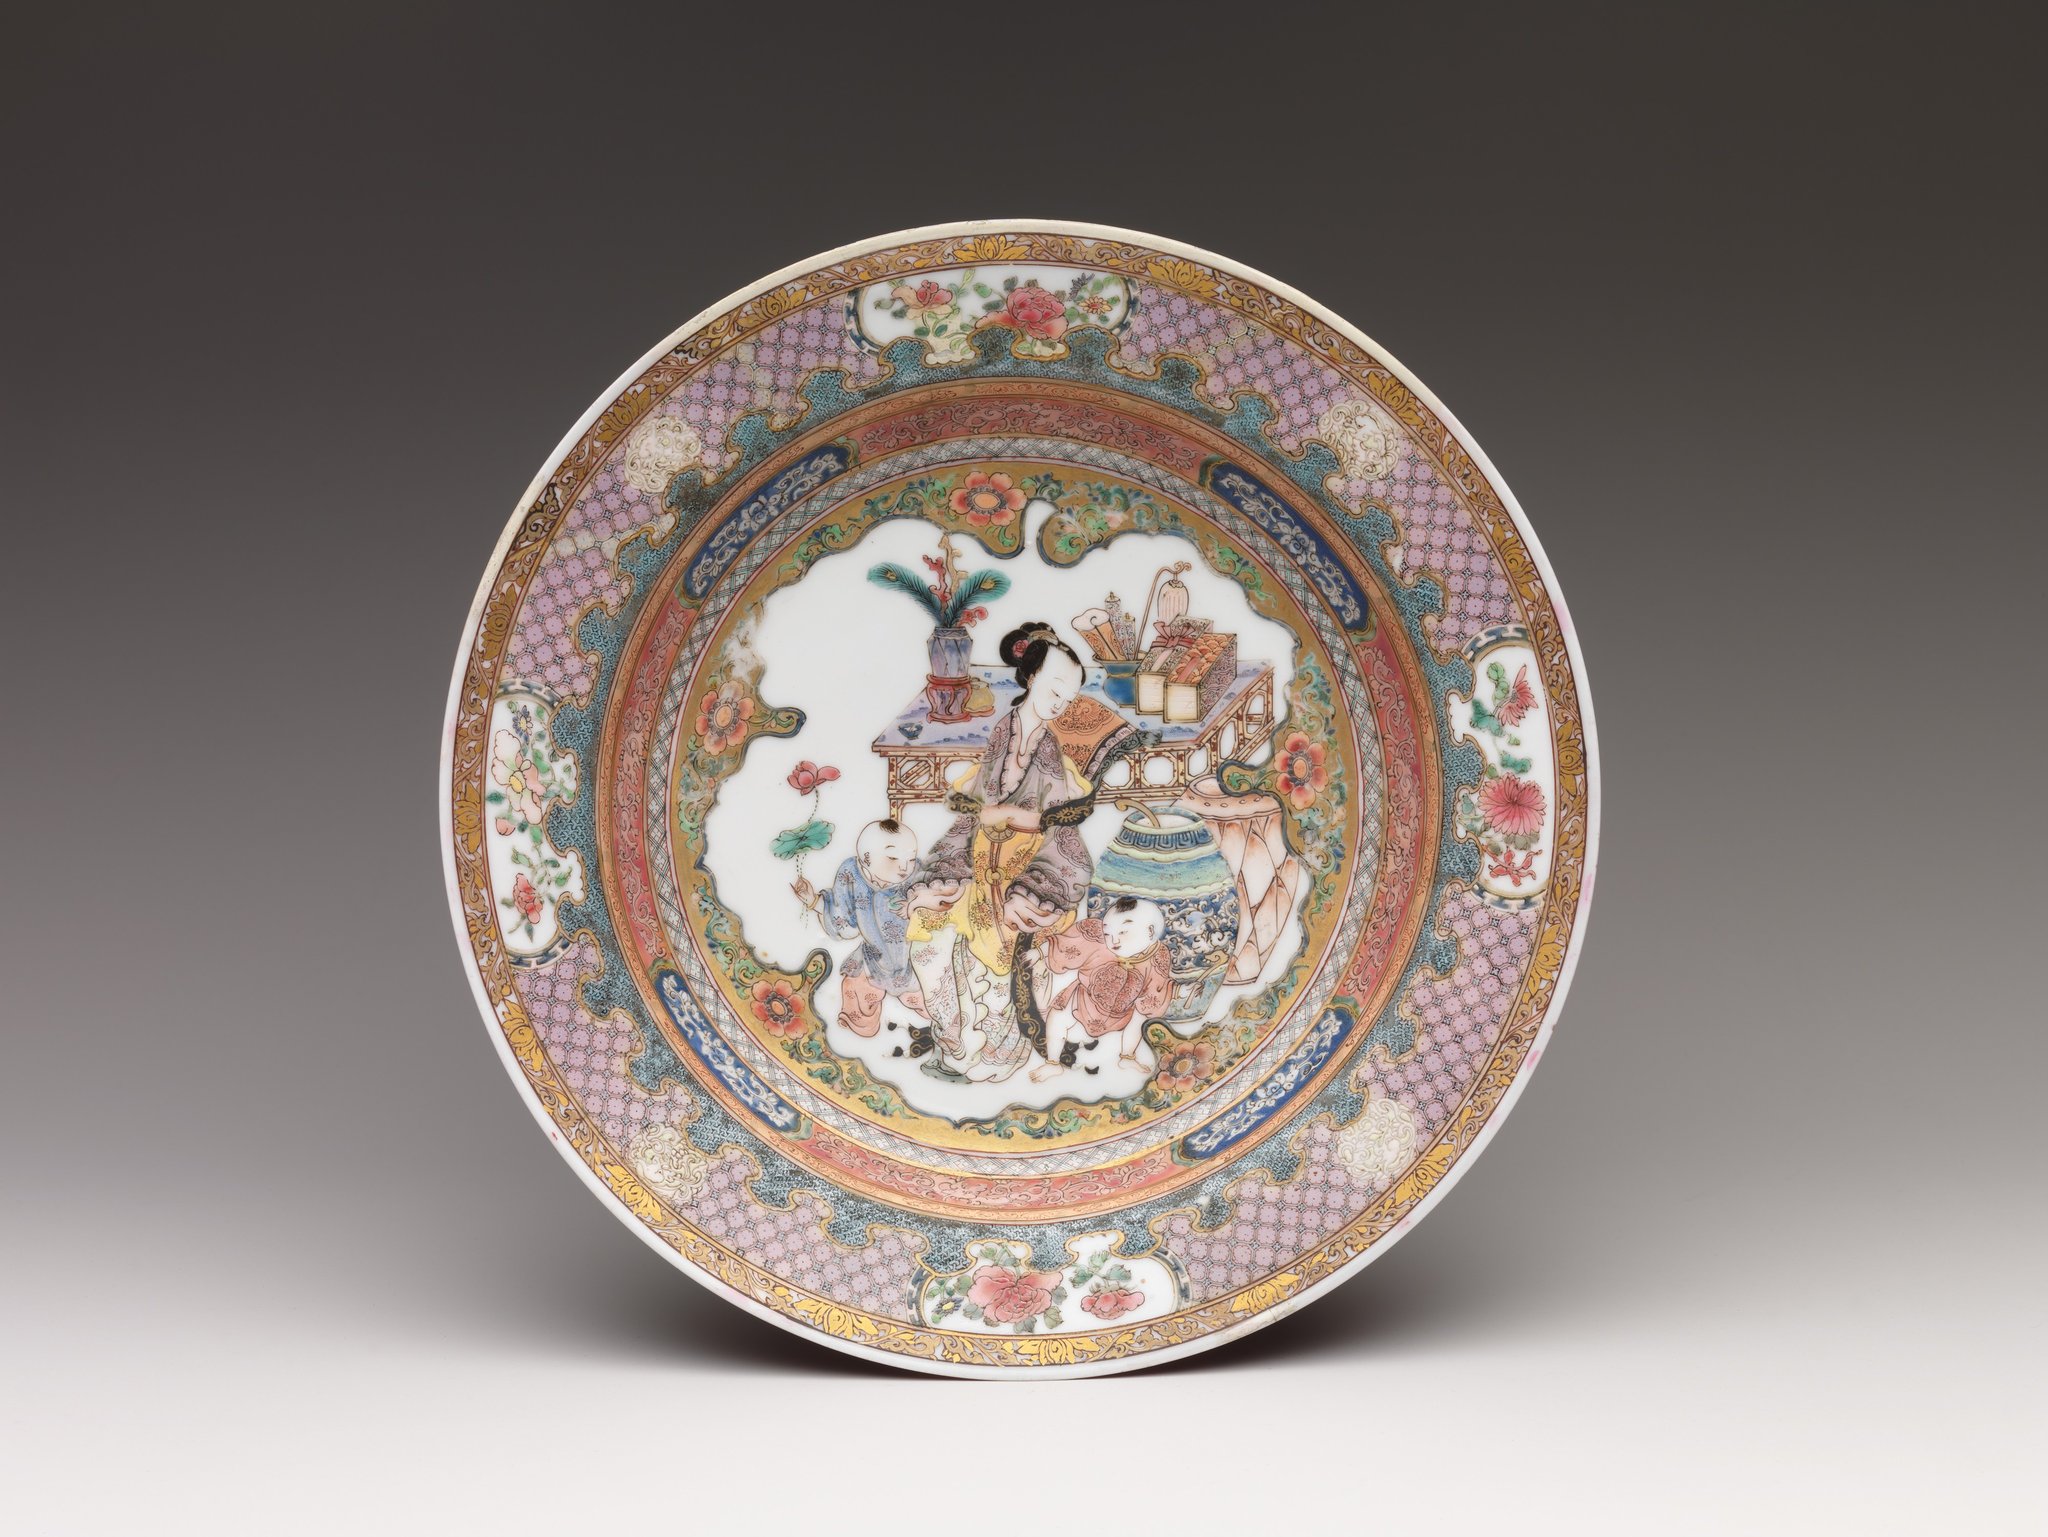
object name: plate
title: Dish with scene of a woman and children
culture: chinese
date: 1734-1766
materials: enamel, gold, porcelain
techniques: overglaze, painting, polychrome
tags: boys,women,roses,tables